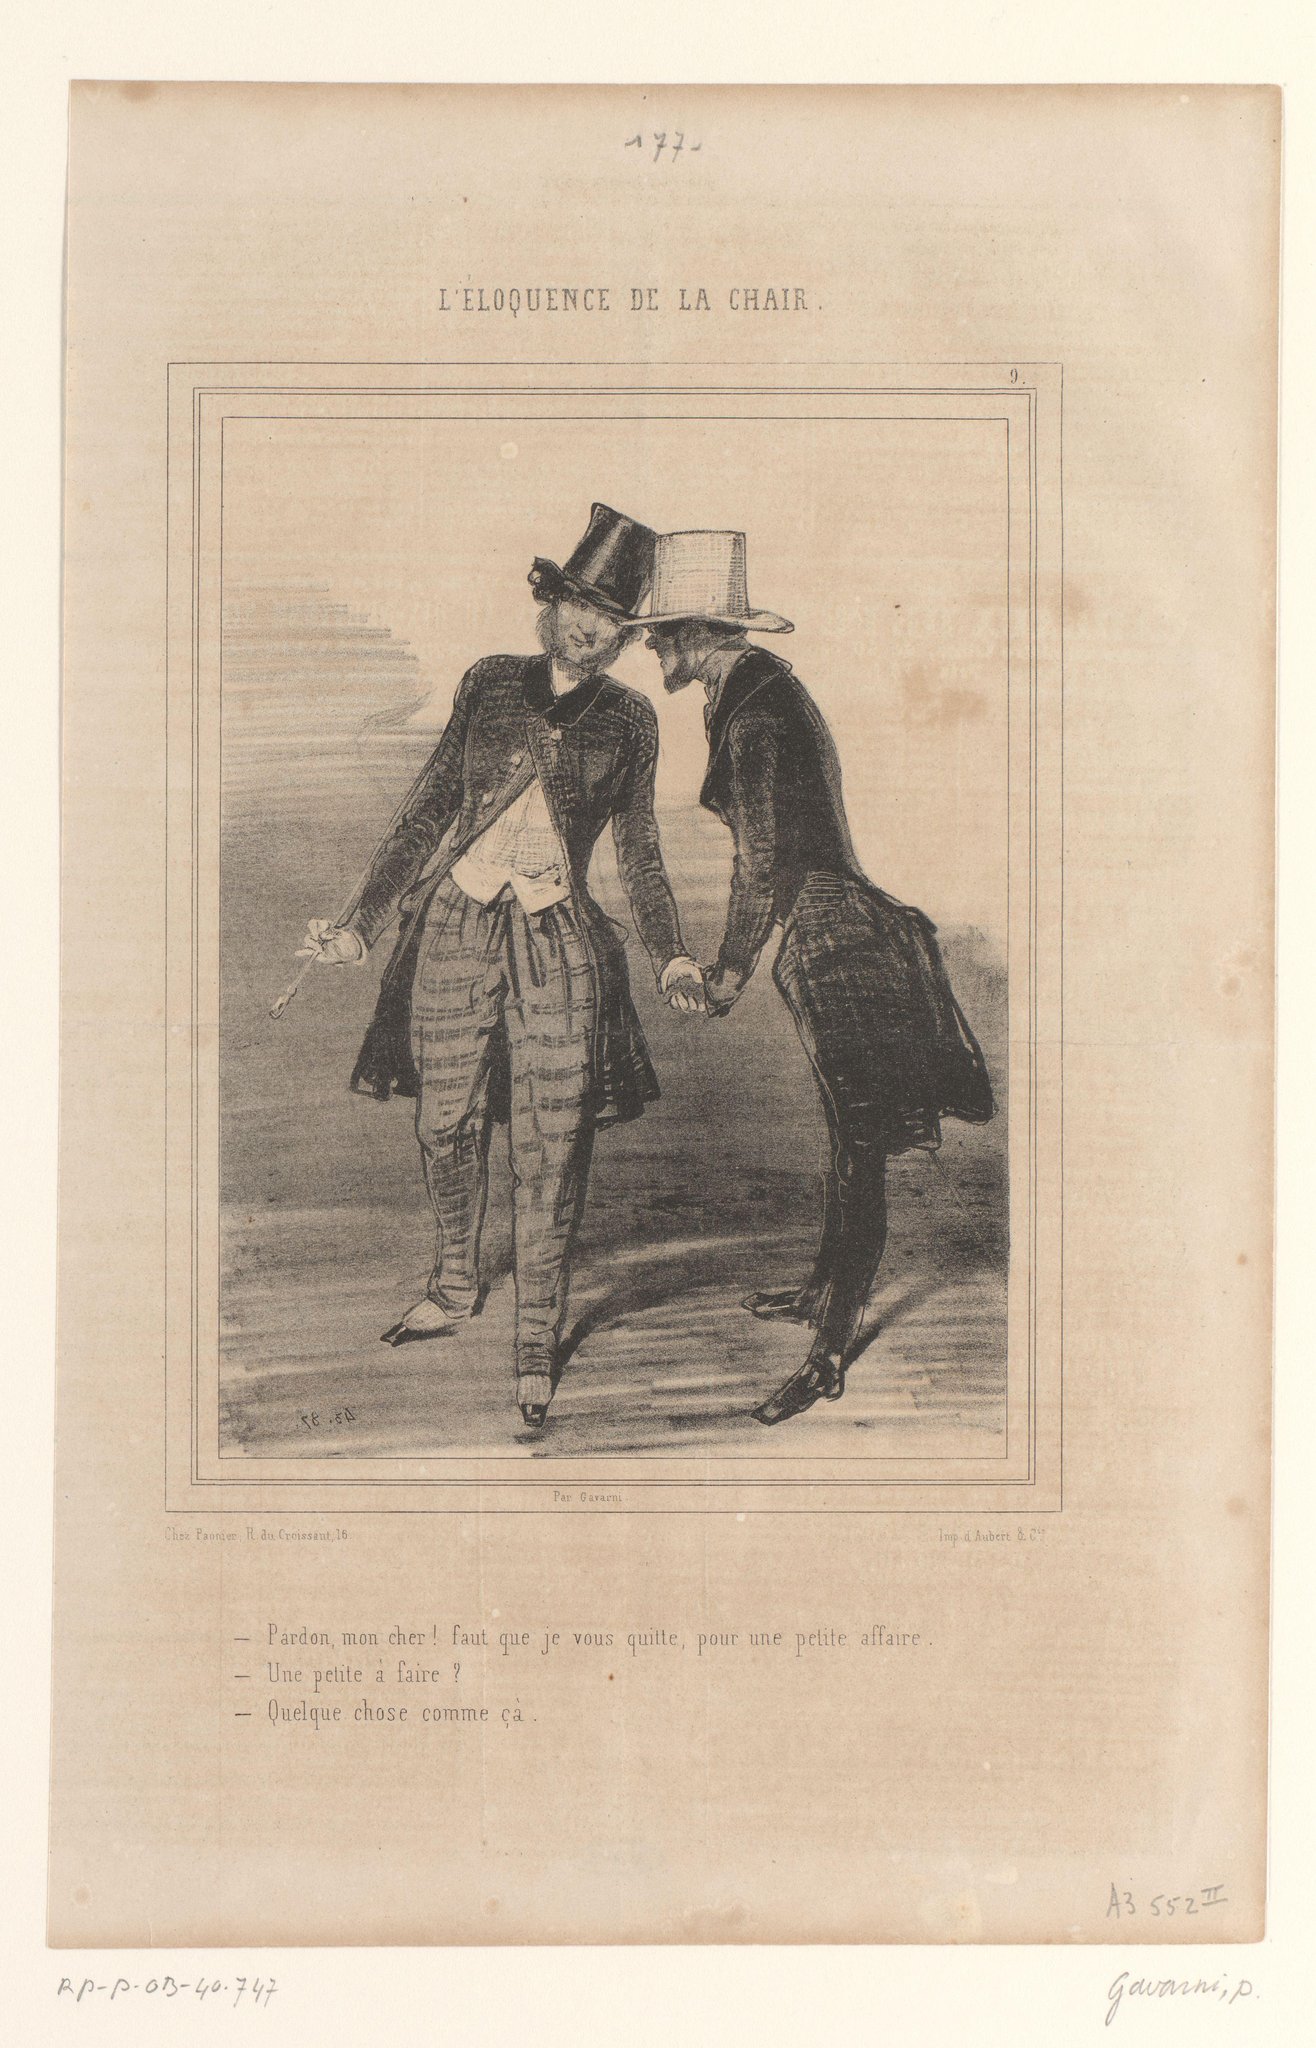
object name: cartoon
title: Welsprekendheid van het vlees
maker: paul gavarni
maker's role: draughtsman, print maker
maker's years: 1804-1866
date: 1843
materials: paper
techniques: lithograph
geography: paris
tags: standing figure, end of a love affair, parting, leave-taking (of lovers), gripping someone by the hand or the wrist; clasped hands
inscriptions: collector's mark: Lugt 2228a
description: De ene man zegt tegen de andere man dat hij hem moet verlaten voor een kleine affaire.